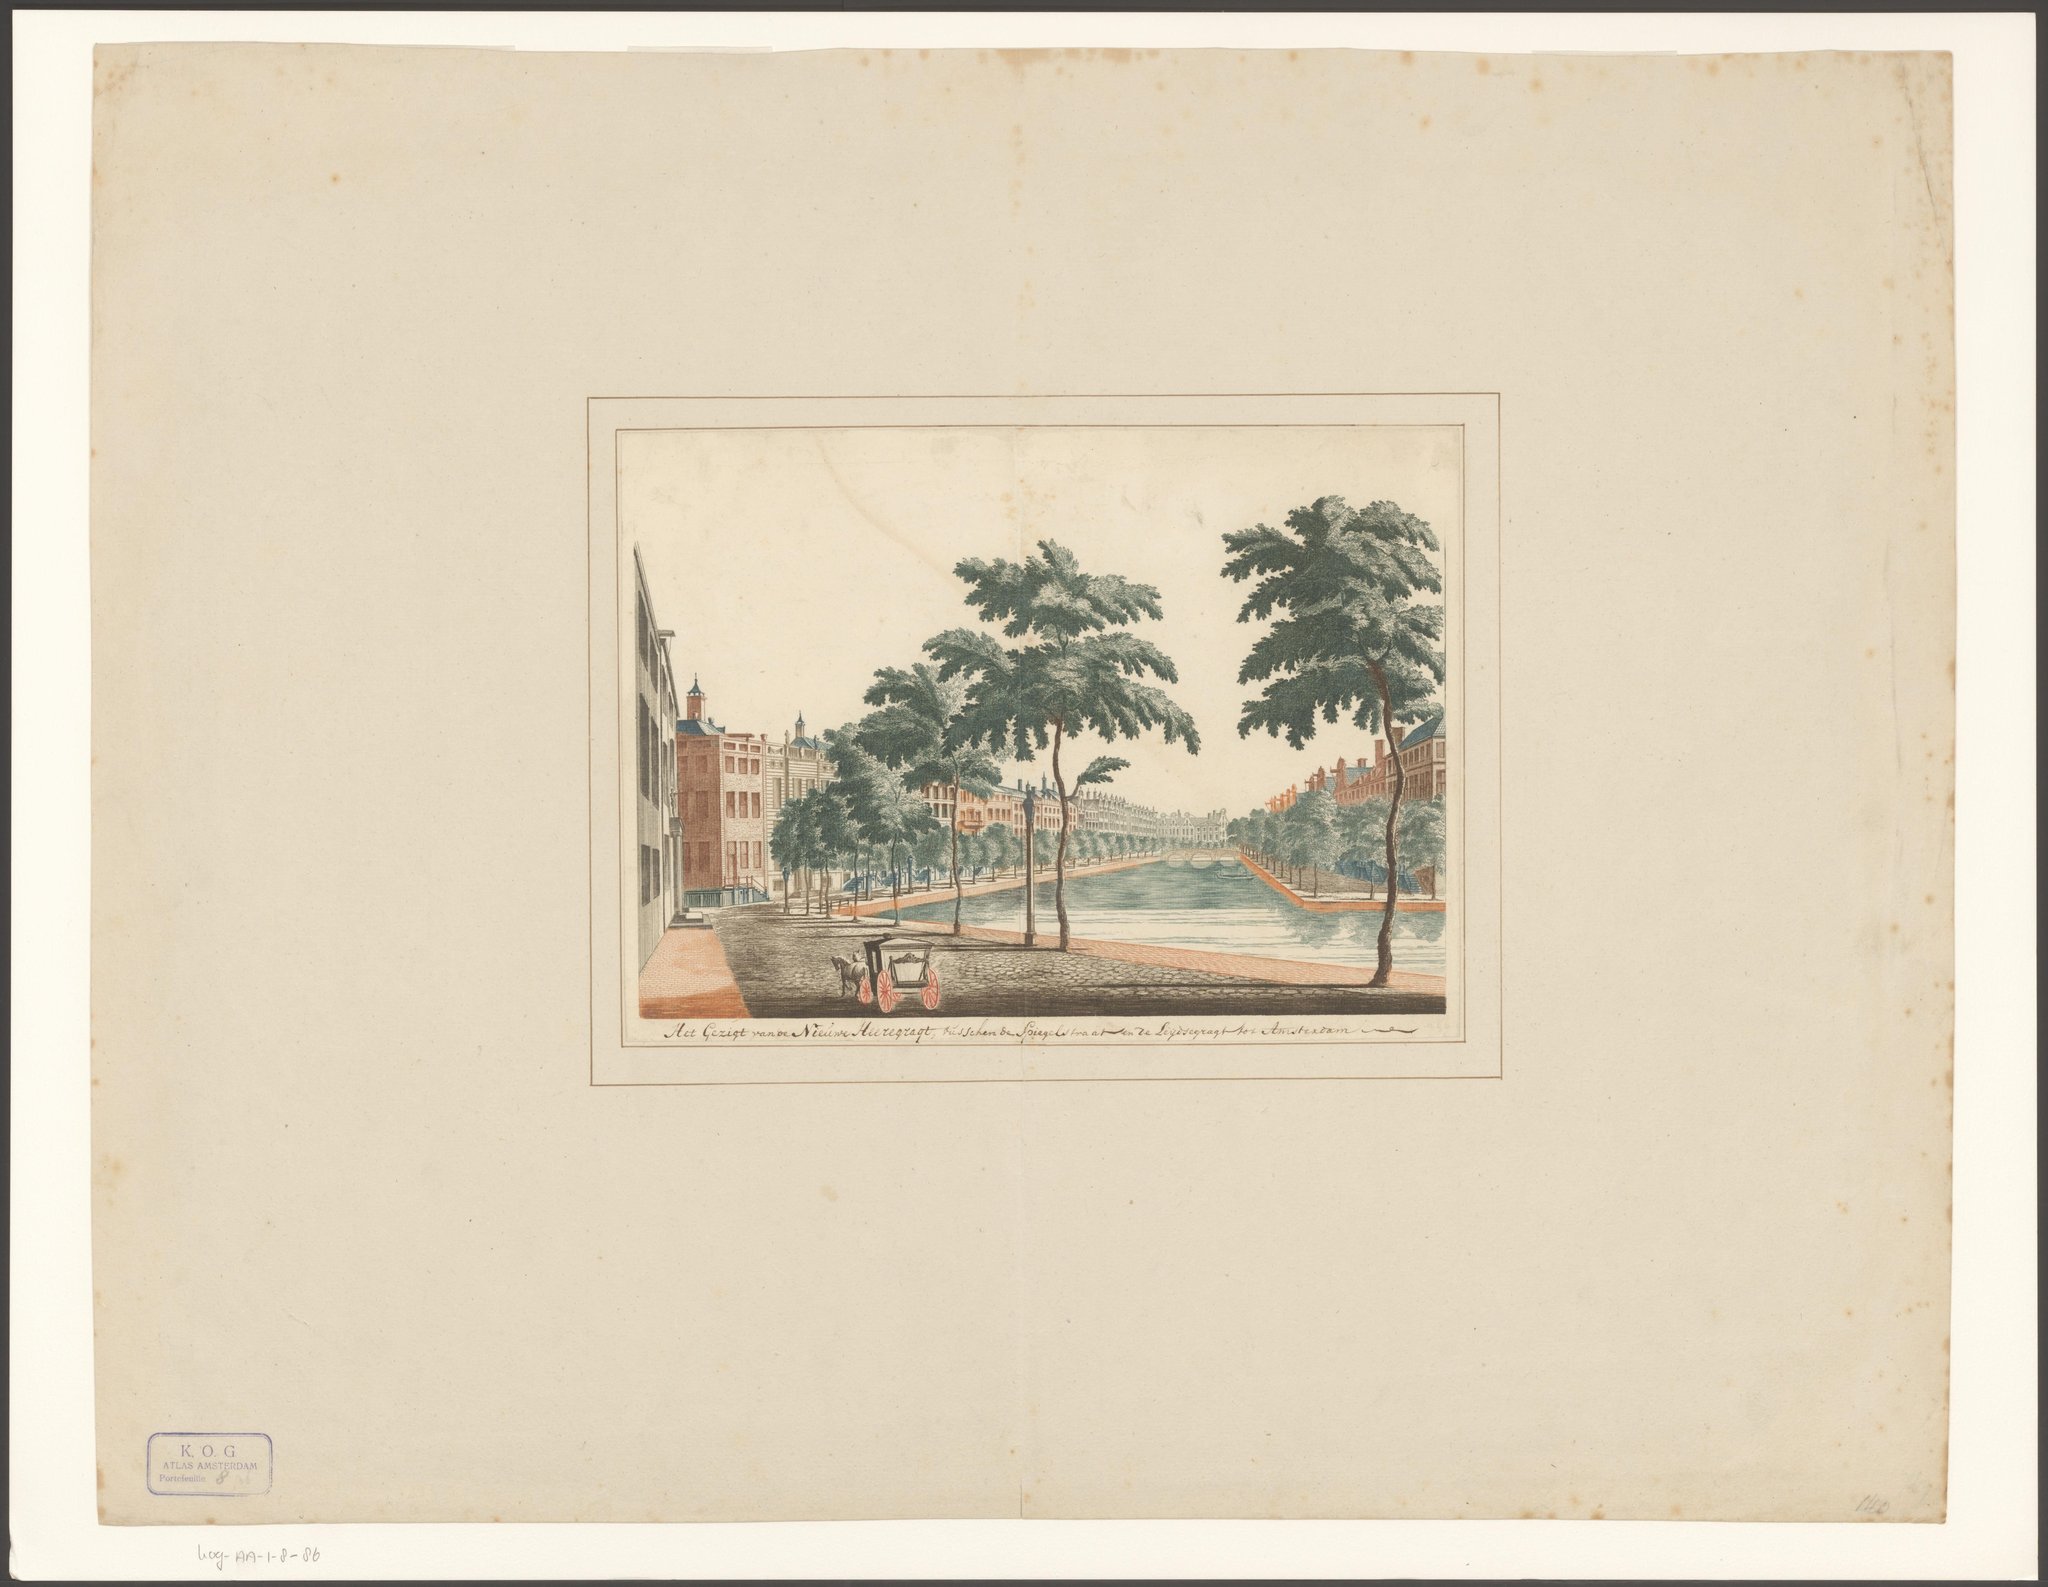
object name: print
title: Het Gezigt van de Nieuwe Heeregragt, tusschen de Spiegelstraat en de Leijdsegragt tot Amsterdam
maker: Anonymous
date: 1650-1750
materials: paper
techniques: color etching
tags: city-view in general; 'veduta', canal, bridge in city across river, canal, etc., two-wheeled vehicle drawn by two animals, street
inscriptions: inscription: ‘Het Gezigt van de Nieuwe Heeregragt, tusschen de Spiegelstraat en de Leijdsegragt tot Amsterdam’, collector's mark: ‘8’ Lugt 1641b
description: Onderwerpsrubriek binnen de Atlas Amsterdam: Haarlemmerplein, Halvemaansteeg, Handboogstraat, Handelskade, Haringpakkerij, Hartenstraat, Hasseltsteeg (Dirk van), Heerengracht.